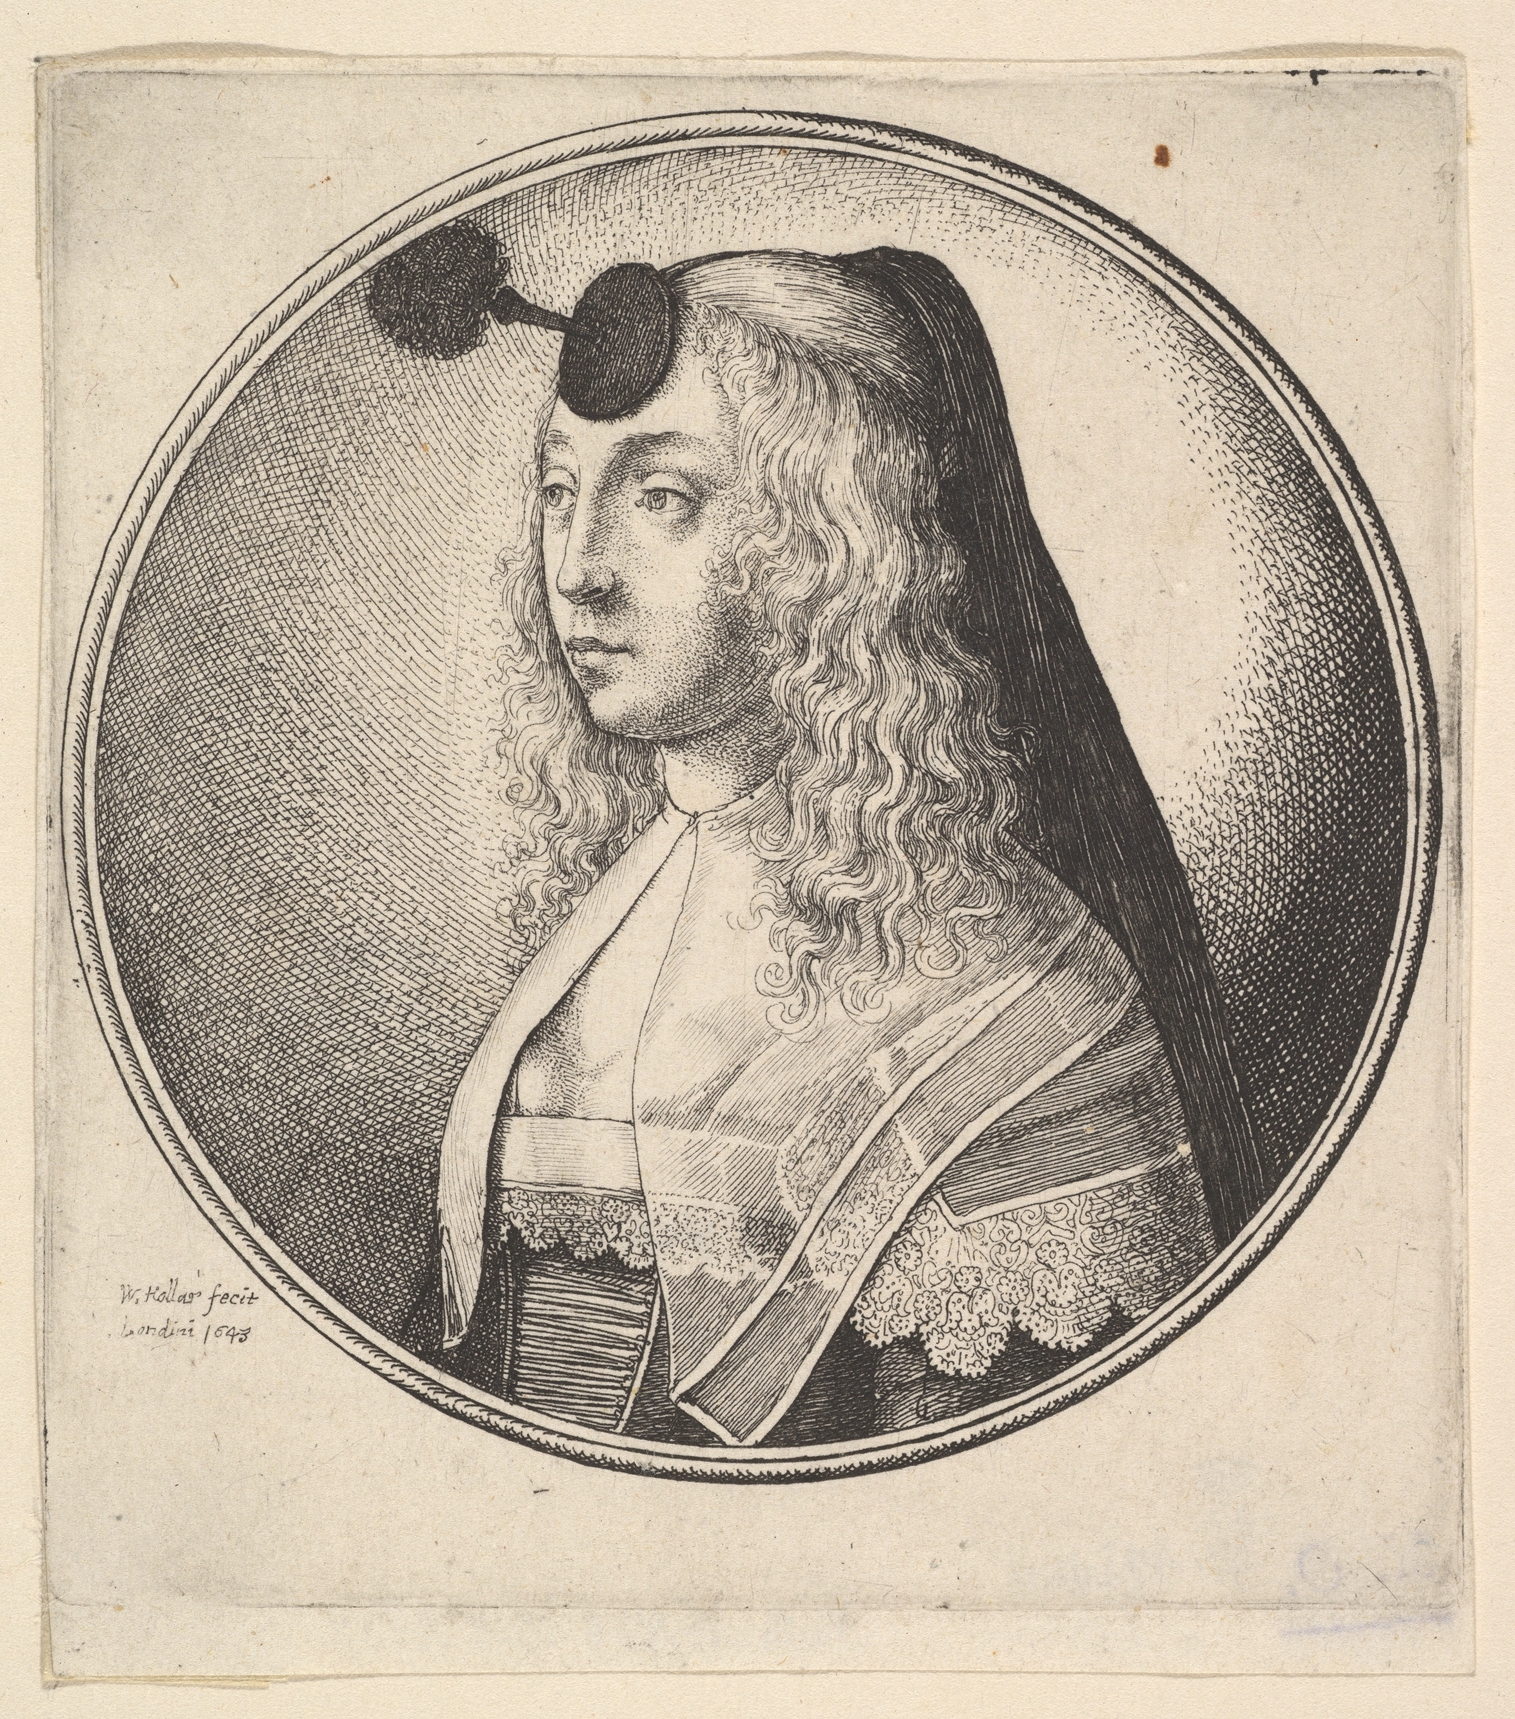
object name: print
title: Woman with houpette on forehead turned to left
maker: wenceslaus hollar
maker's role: artist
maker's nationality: bohemian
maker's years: 1607-1677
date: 1643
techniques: etching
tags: portraits,women